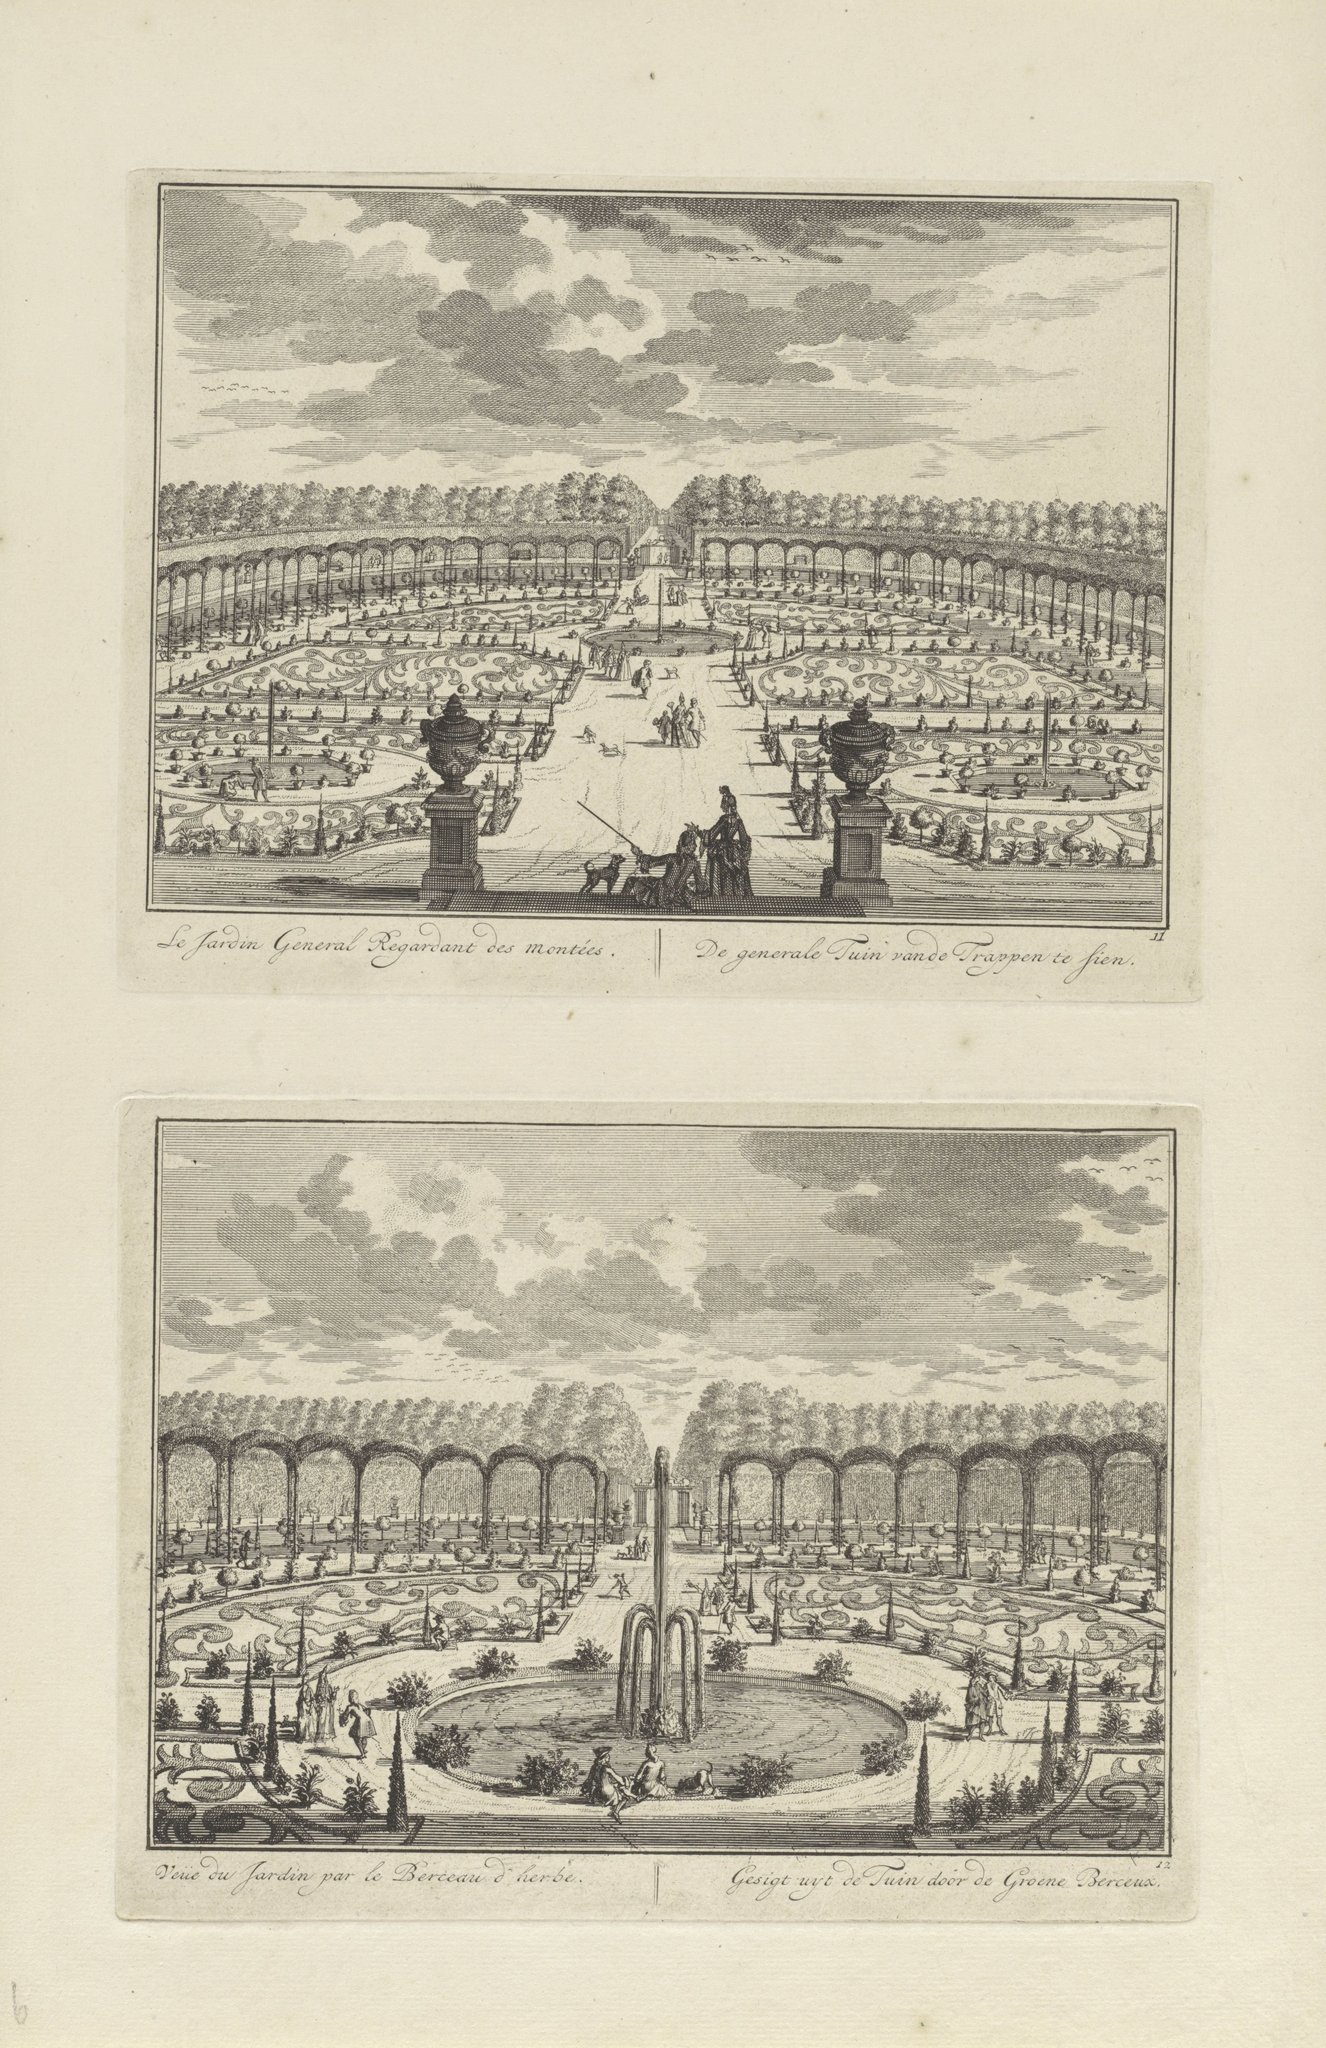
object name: print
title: Gezicht op de tuinen vanaf de trap aan de achterzijde van Slot Zeist / Gezicht op de tuin van Slot Zeist vanuit de berceau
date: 1682-1726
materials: paper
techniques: etching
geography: amsterdam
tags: garden fountain, french or architectonic garden; formal garden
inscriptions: collector's mark: Lugt 2228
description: Twee voorstellingen op een blad. Boven: Gezicht op de tuinen vanaf de trap aan de achterzijde van Slot Zeist. Onder: Gezicht op de tuin met vijver en fontein bij Slot Zeist vanuit de berceau.